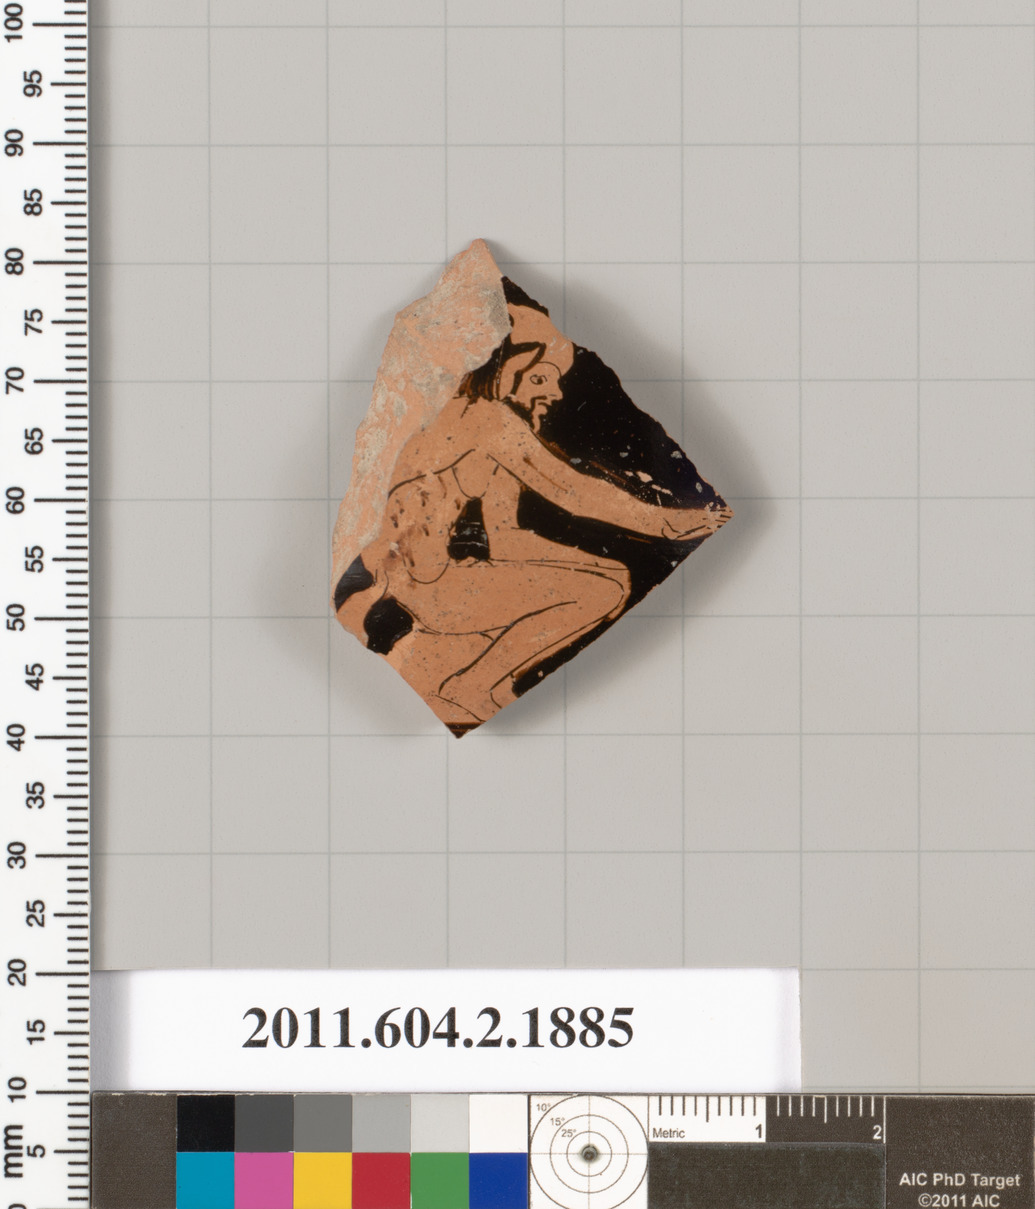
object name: skyphos fragment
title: Terracotta fragment of a skyphos (deep drinking cup)?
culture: greek, attic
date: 467-435 BCE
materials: terracotta